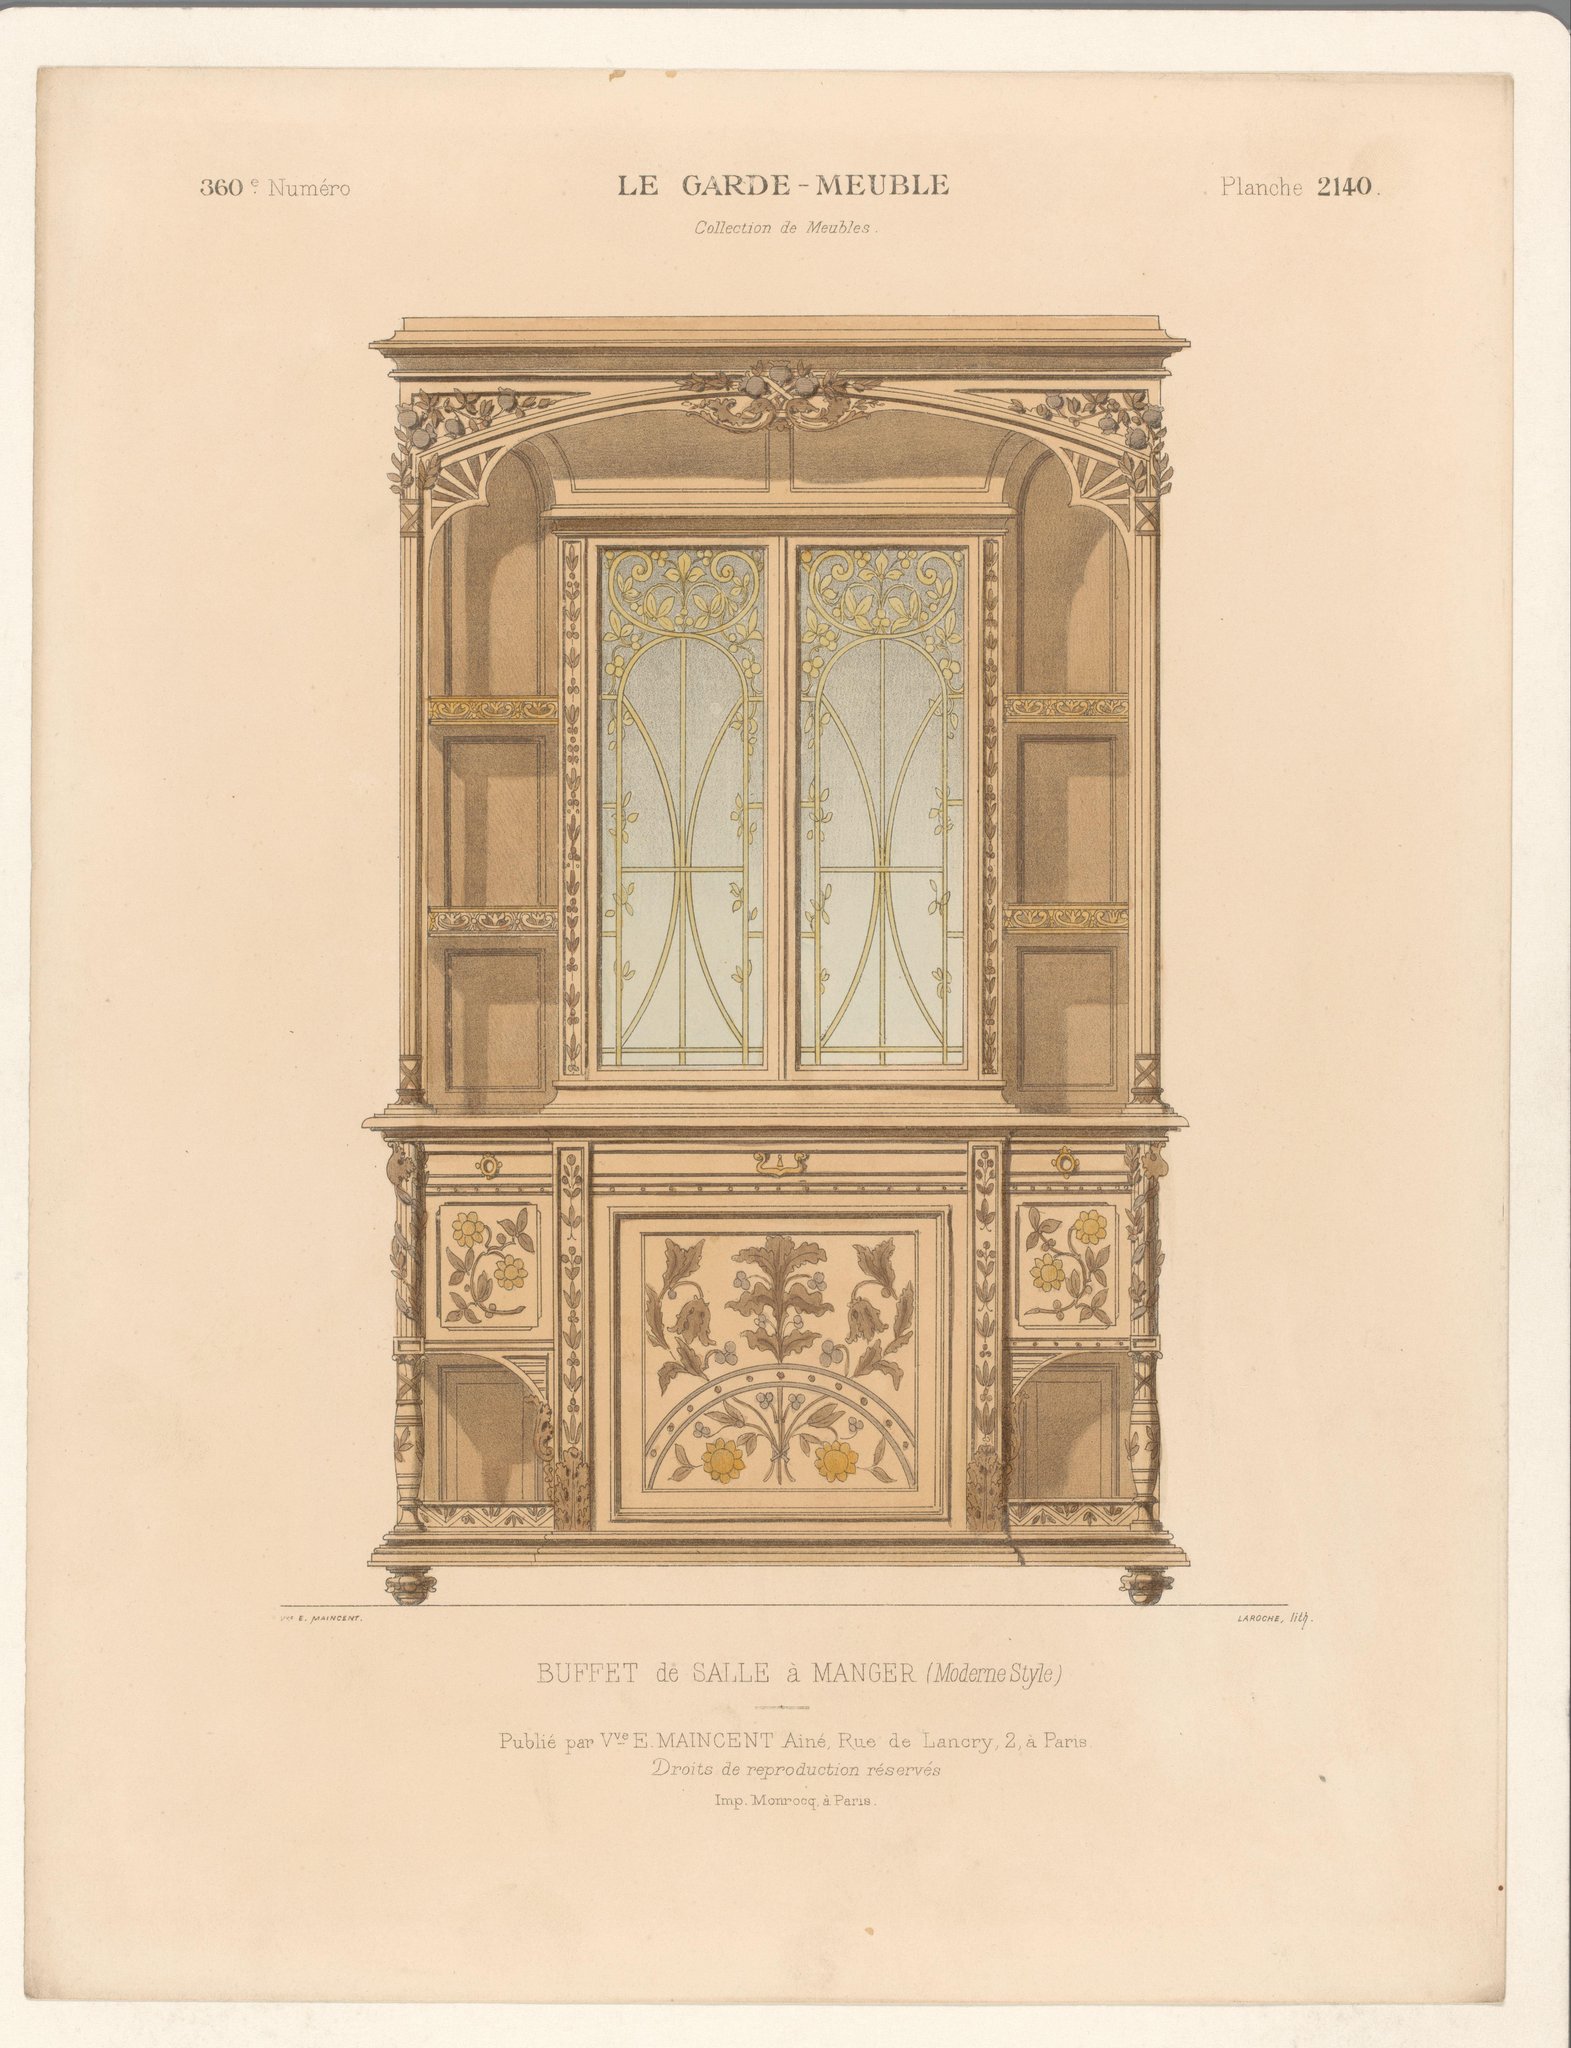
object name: print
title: Buffet de salle à manger (Moderne Style)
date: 1895-1935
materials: paper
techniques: hand coloring, lithograph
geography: paris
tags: furniture for storage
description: Ieder Livraison in de serie Le Garde-Meuble bevat negen platen: drie 'sièges' (zitmeubels), drie 'meubles' (diverse meubels zoals tafels en kasten) en drie 'tentures' (gordijnen en draperieën).